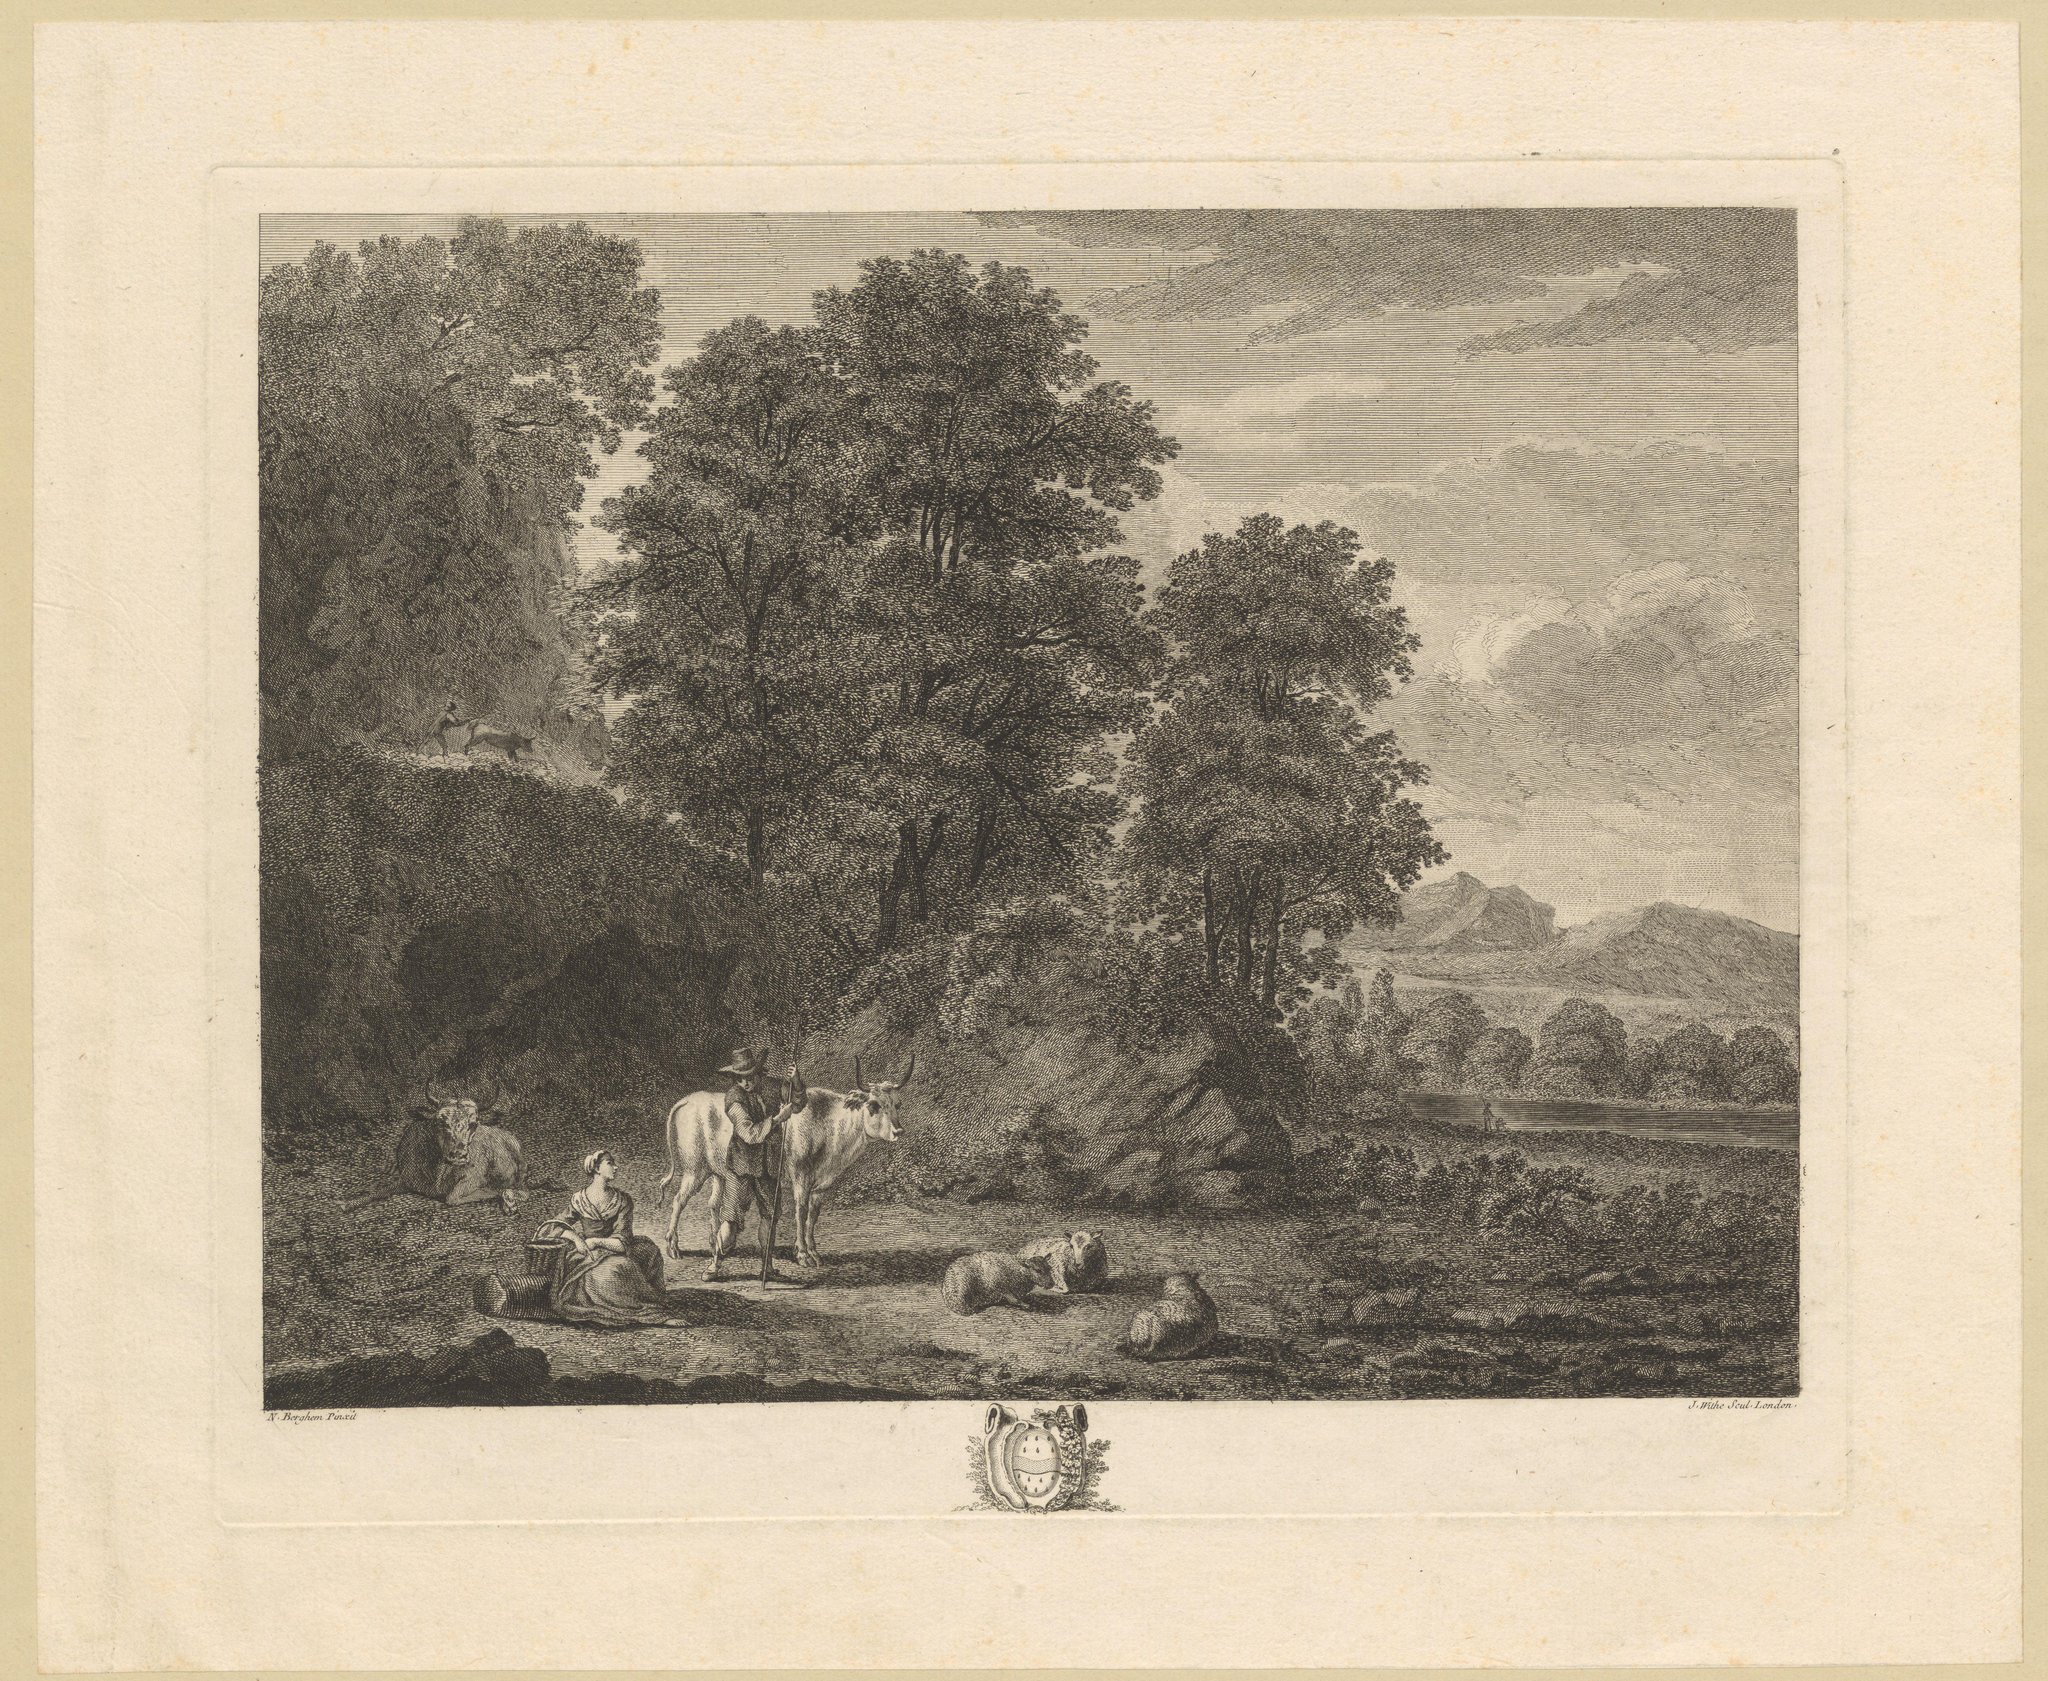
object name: print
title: Landschap bij een rivier met herder, herderin, twee koeien en drie schapen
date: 1753-1799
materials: paper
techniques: etching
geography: london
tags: cow, river, herding, herdsman, herdswoman, shepherd, shepherdess, cowherd, etc., sheep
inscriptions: collector's mark: Lugt 240